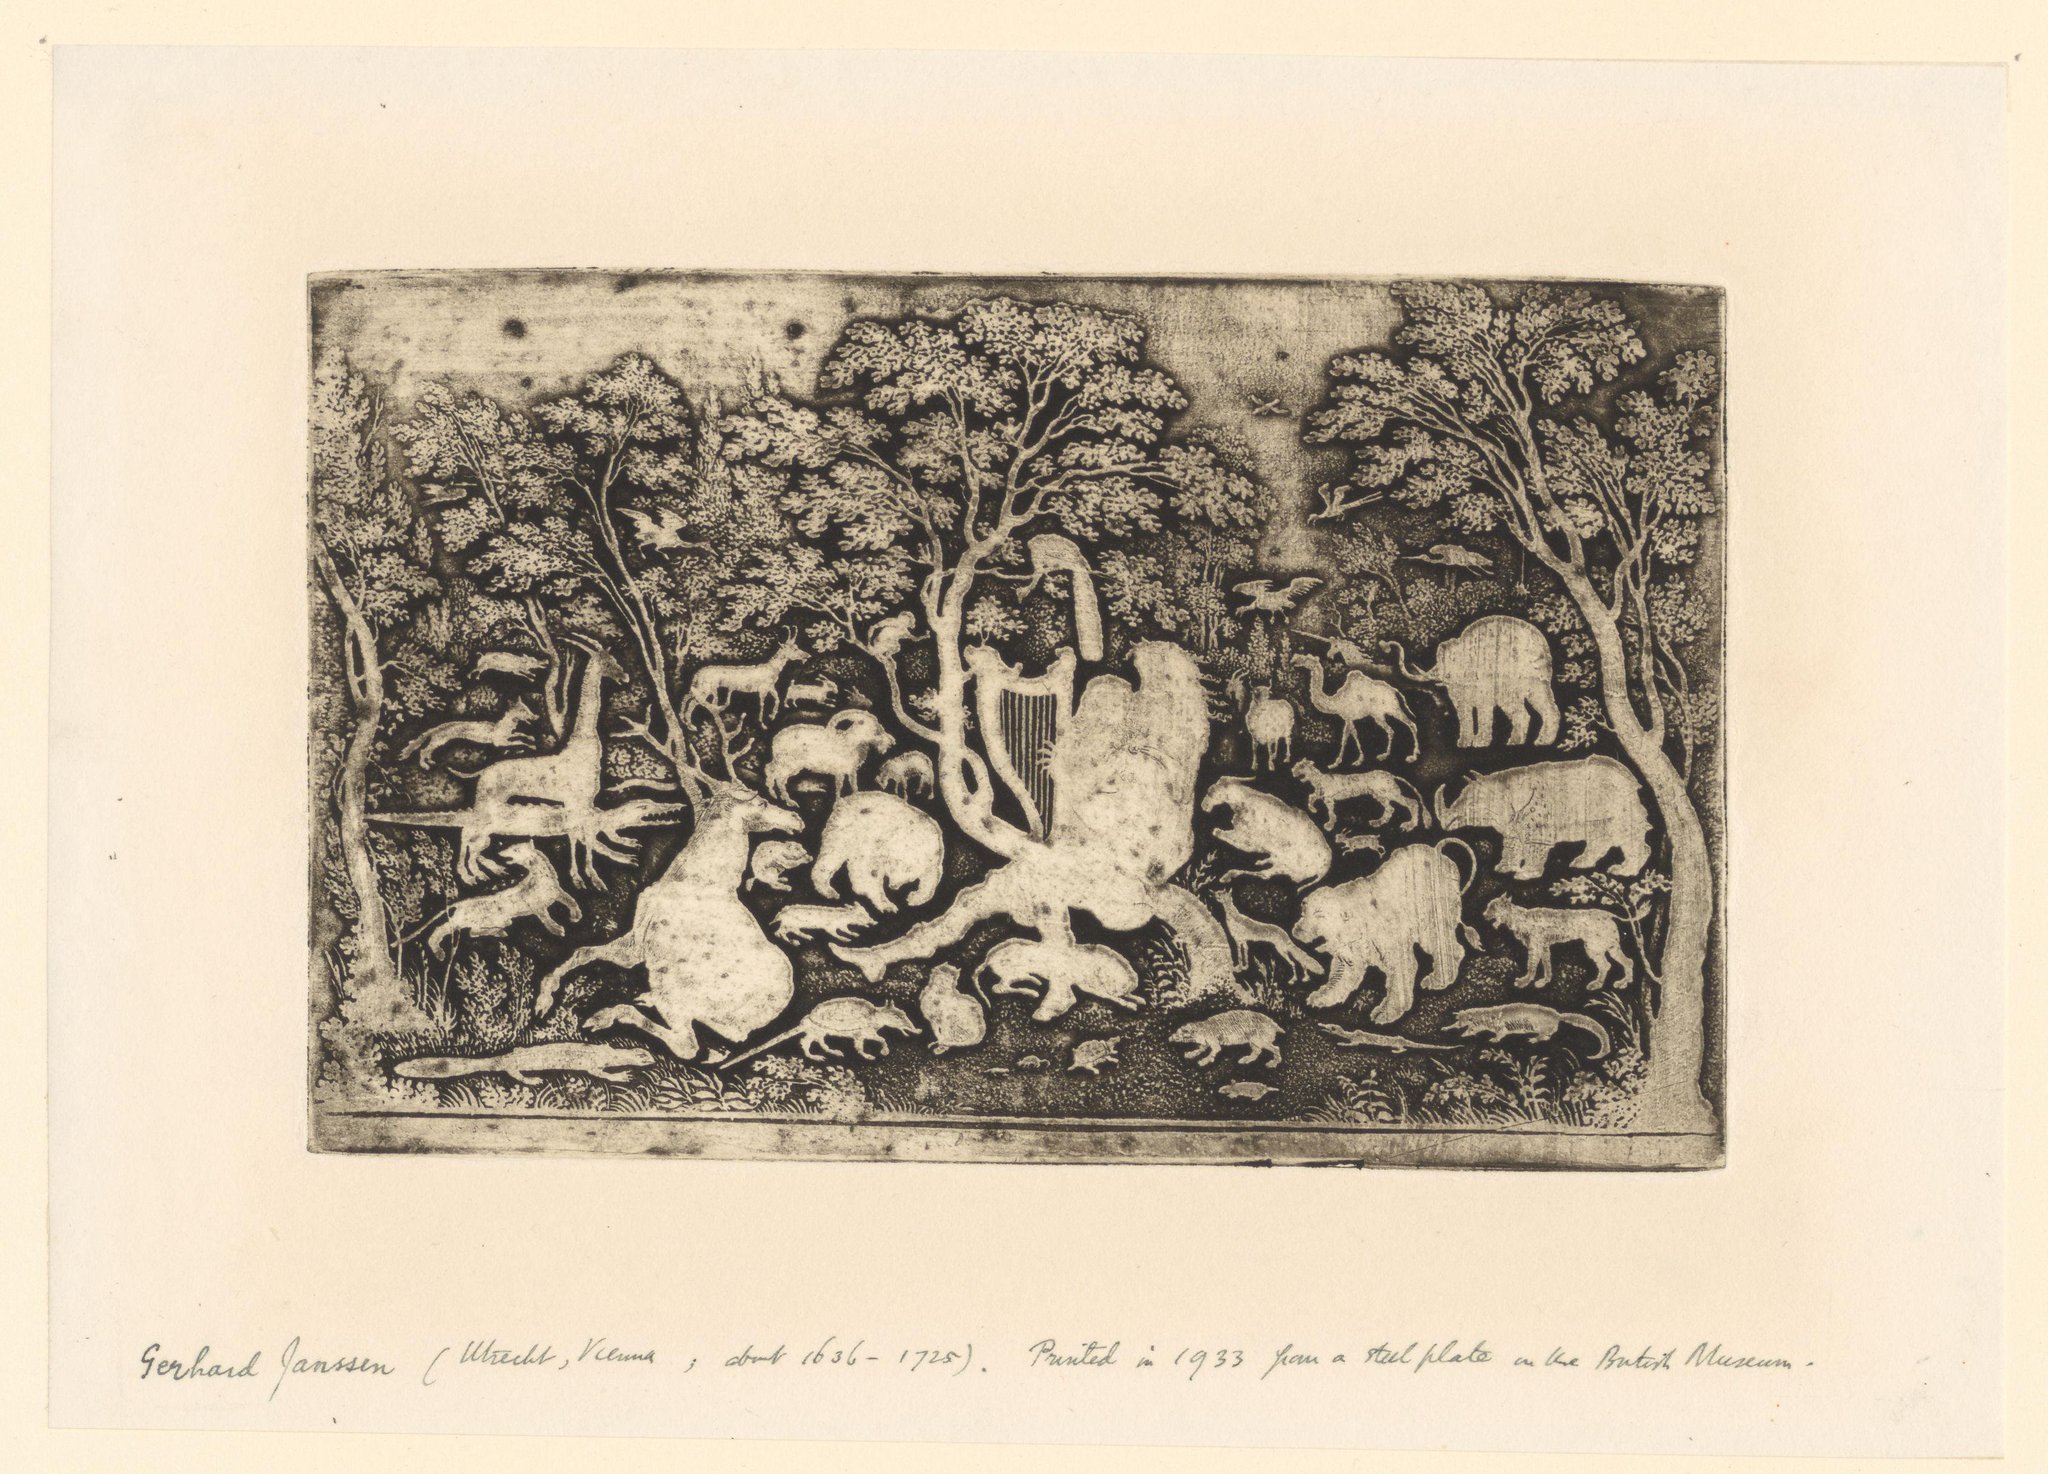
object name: print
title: Orpheus betovert de natuur met zijn lier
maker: gerhard janssen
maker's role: print maker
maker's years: 1636-1725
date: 1717-1718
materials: paper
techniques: etching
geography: vienna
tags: orpheus playing the lyre: trees and rocks move, beasts and birds are enchanted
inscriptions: collector's mark: Lugt 2228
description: Deze prent is één van de twee afdrukken van de versleten plaat uit 1933. De andere prent en de plaat bevinden zich beide in de collectie van het British Museum Londen onder inv. nr. 1862,1011.185 (plaat) en 1933,0531.17 (prent).